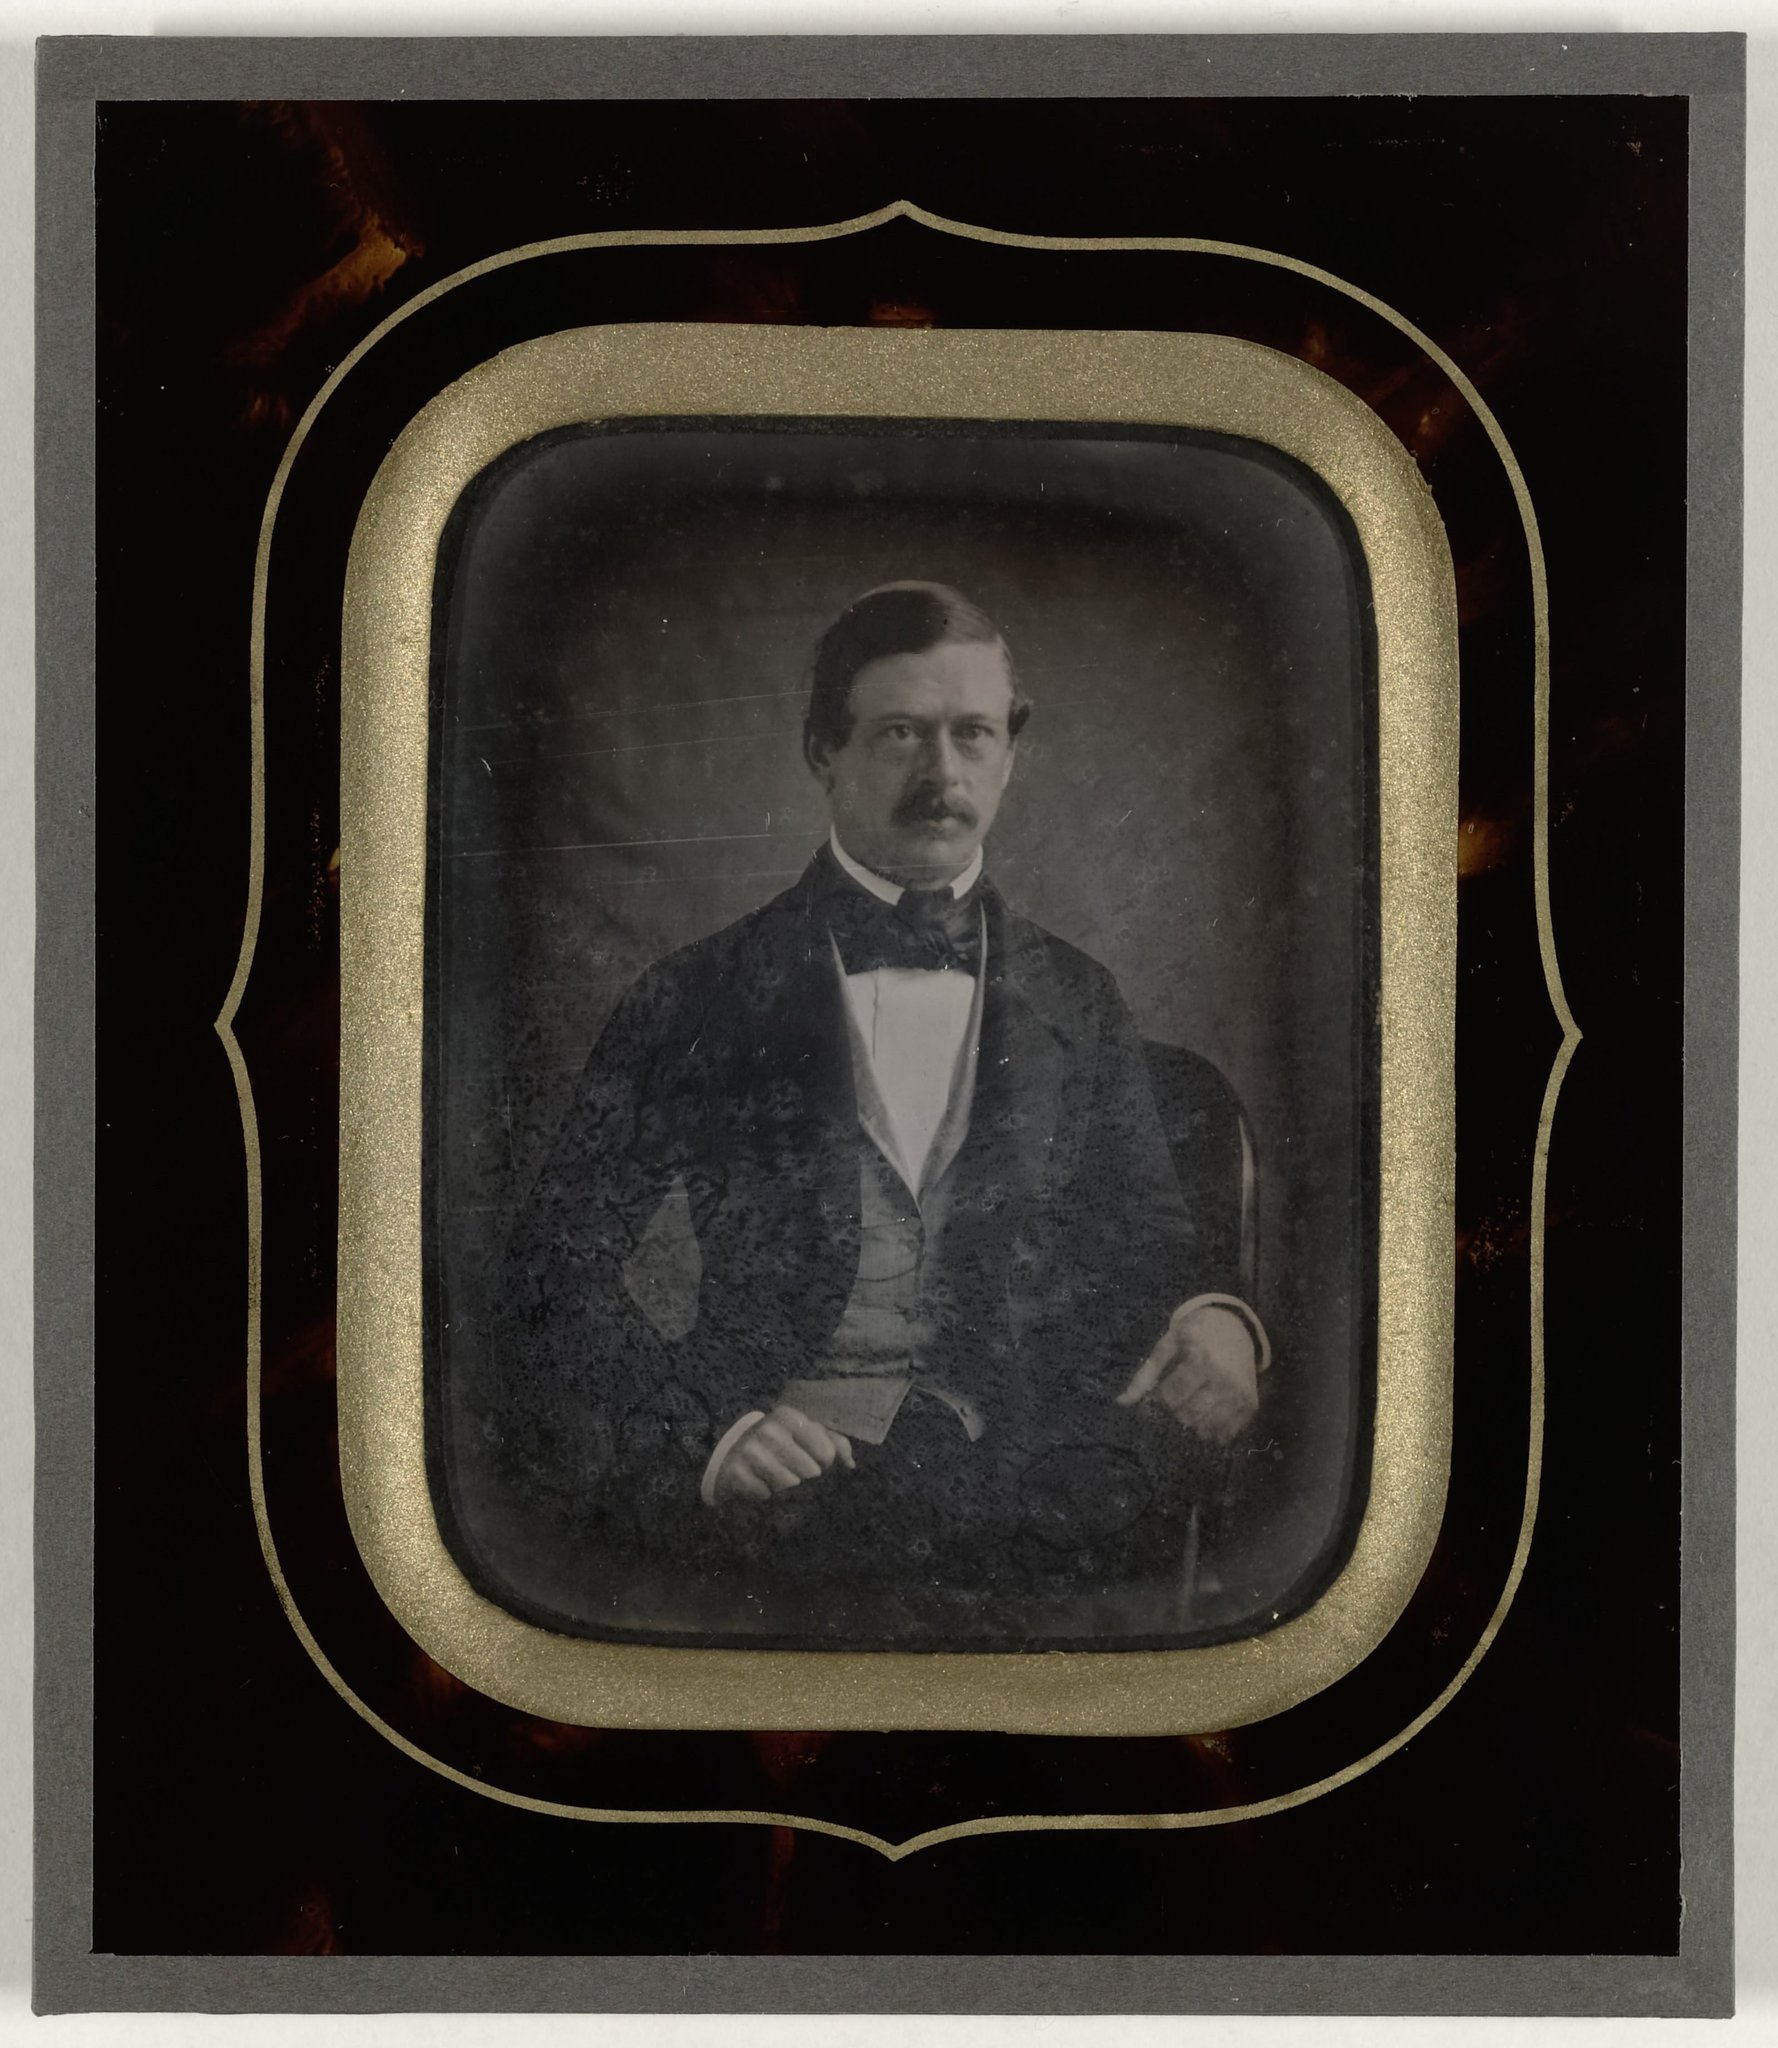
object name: photograph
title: Portret in lijst van Frans Jacob Broers, officier van administratie bij de marine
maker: Anonymous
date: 1850-1860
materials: copper, glass, paper, silver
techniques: daguerreotype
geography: netherlands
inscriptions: annotation: ‘Frans Jacob Broers / getr. met / W.H. Faure’